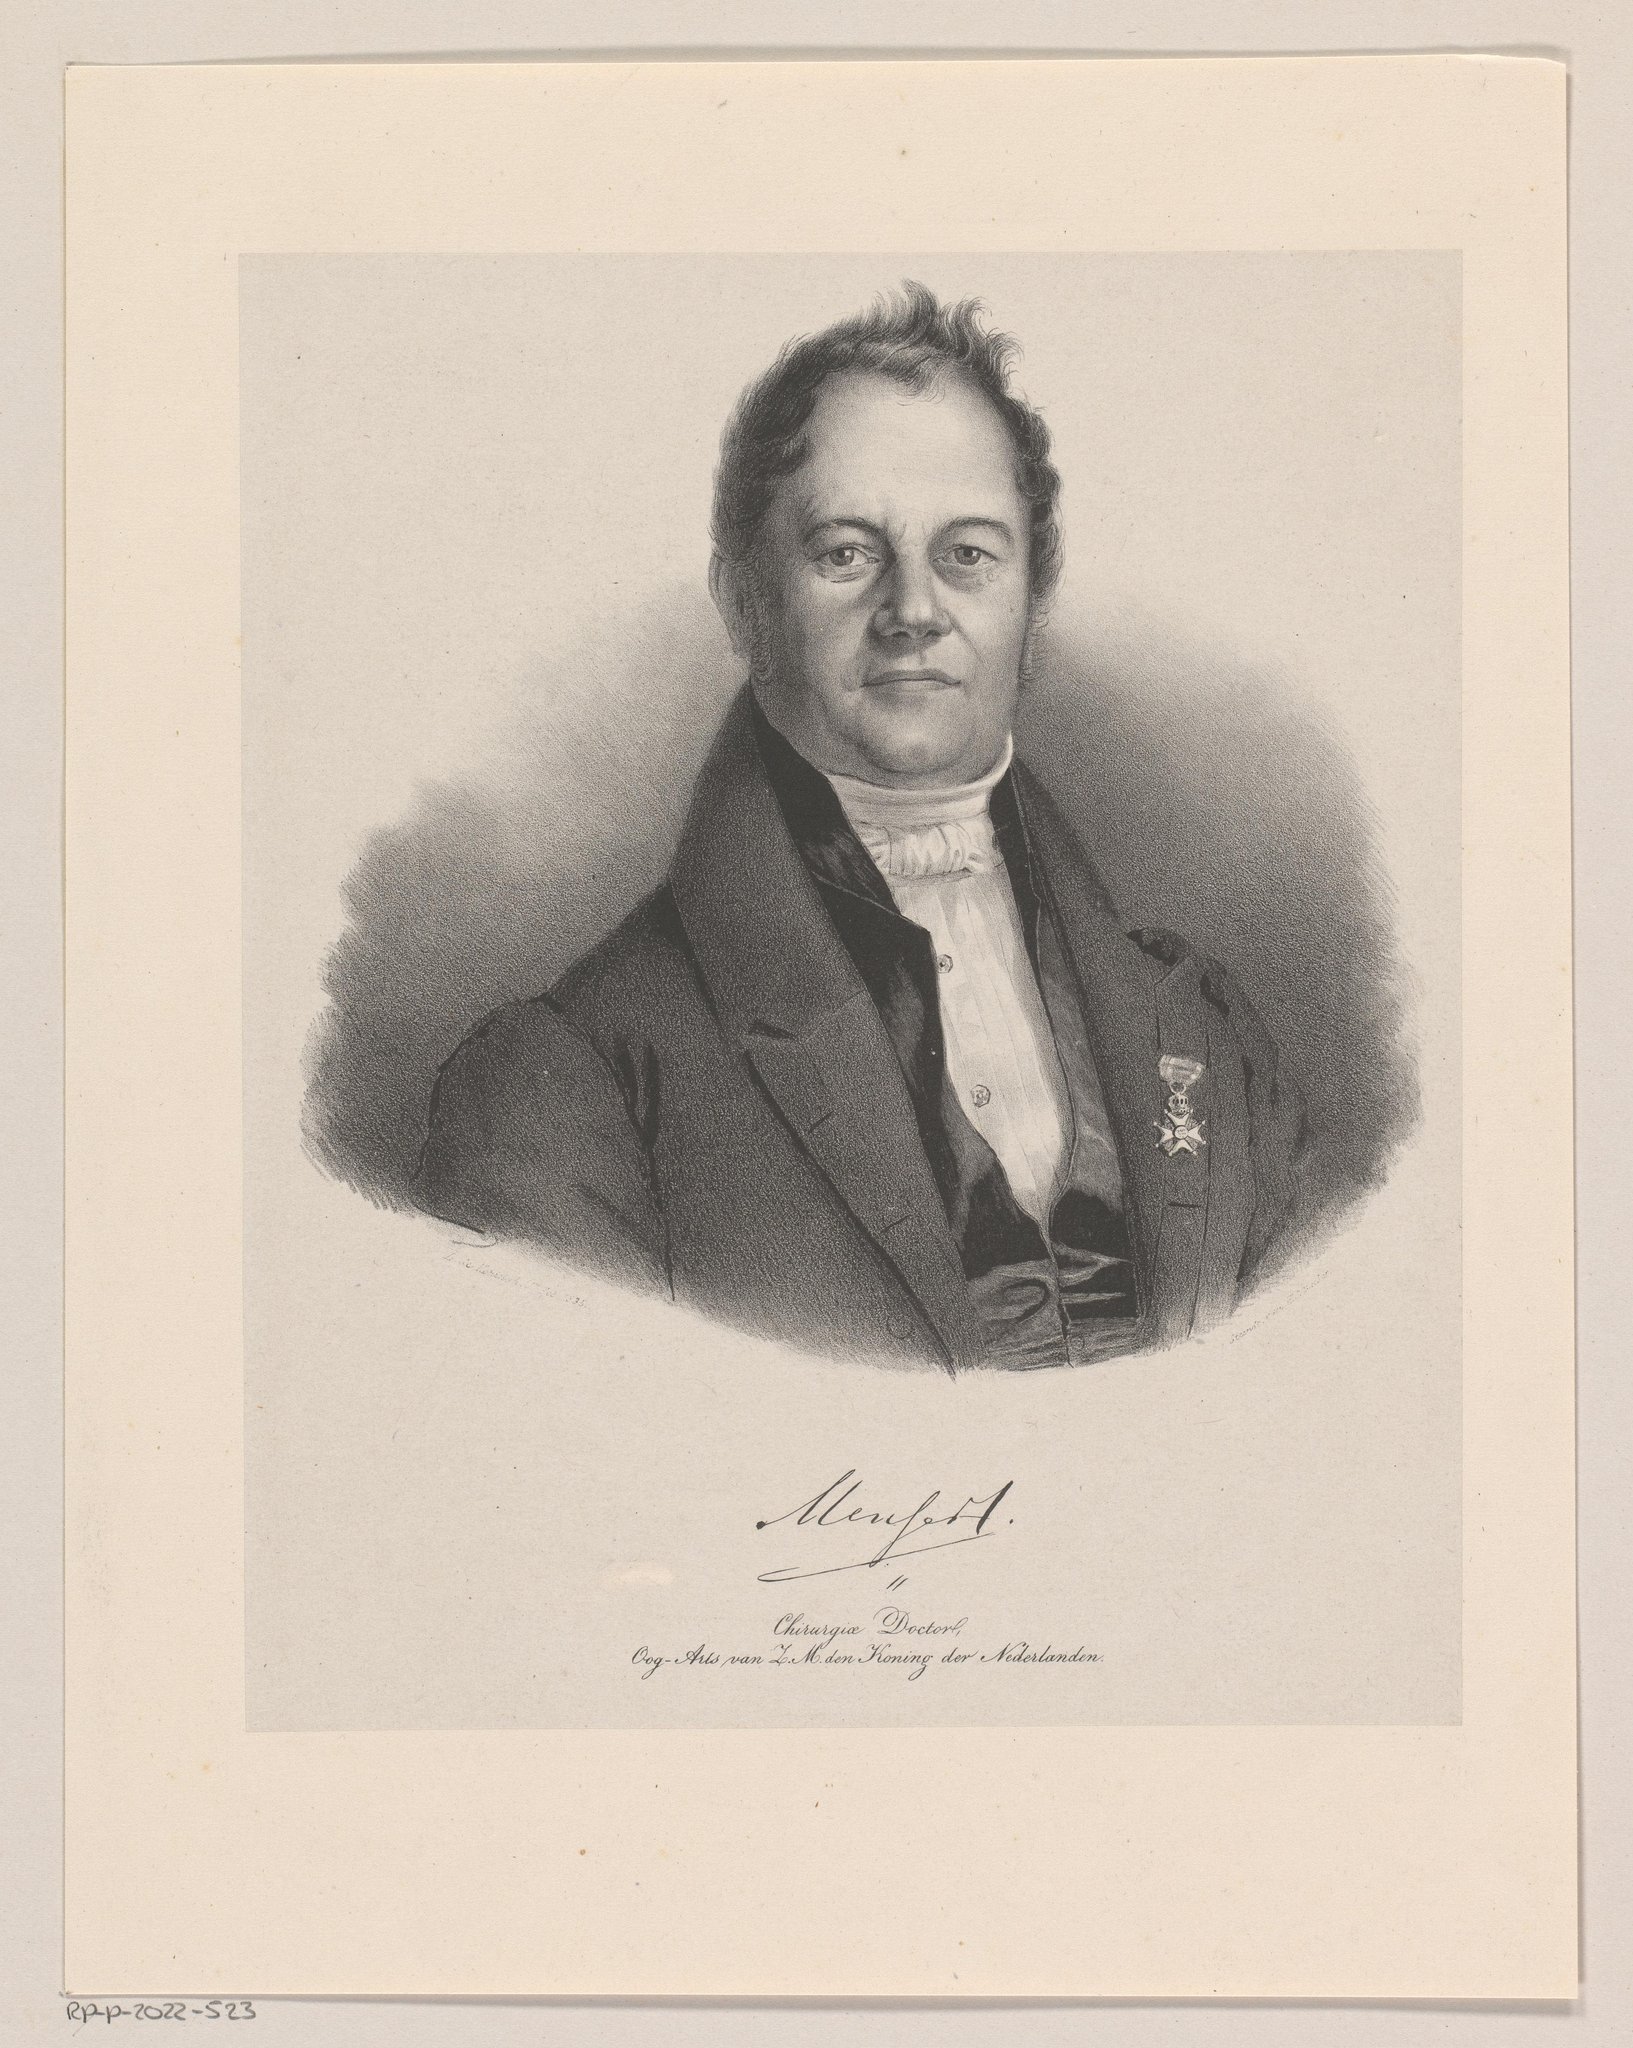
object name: print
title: Portret van Willem Mensert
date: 1835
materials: paper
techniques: lithograph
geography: dordrecht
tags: knighthood order, historical persons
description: Met facsimile signatuur van geportretteerde.